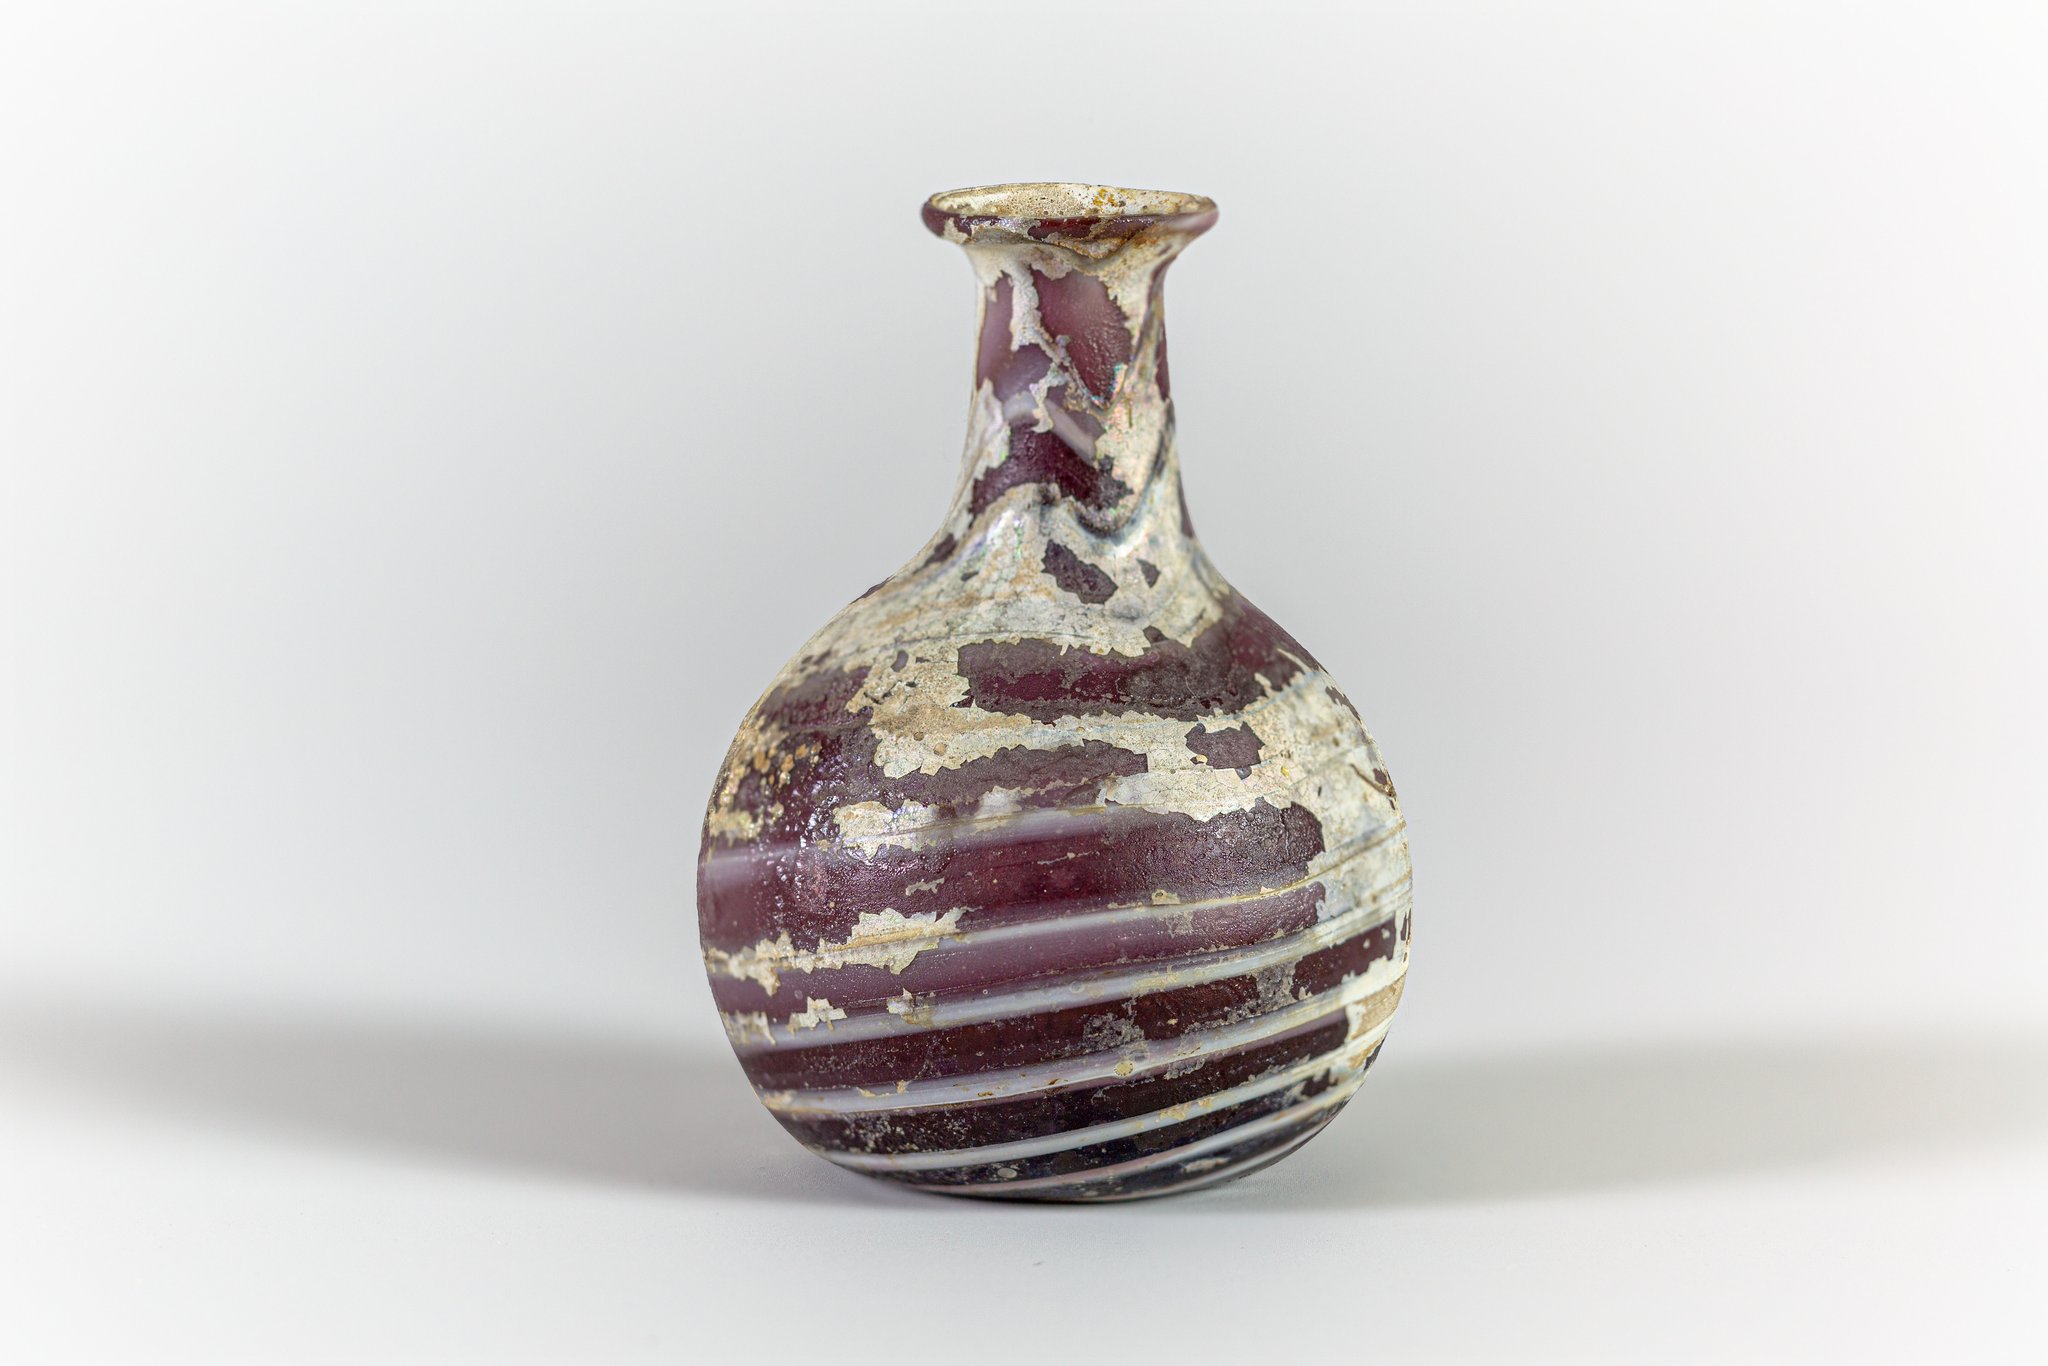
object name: perfume bottle, marbled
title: Glass perfume bottle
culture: roman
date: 1-100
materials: glass